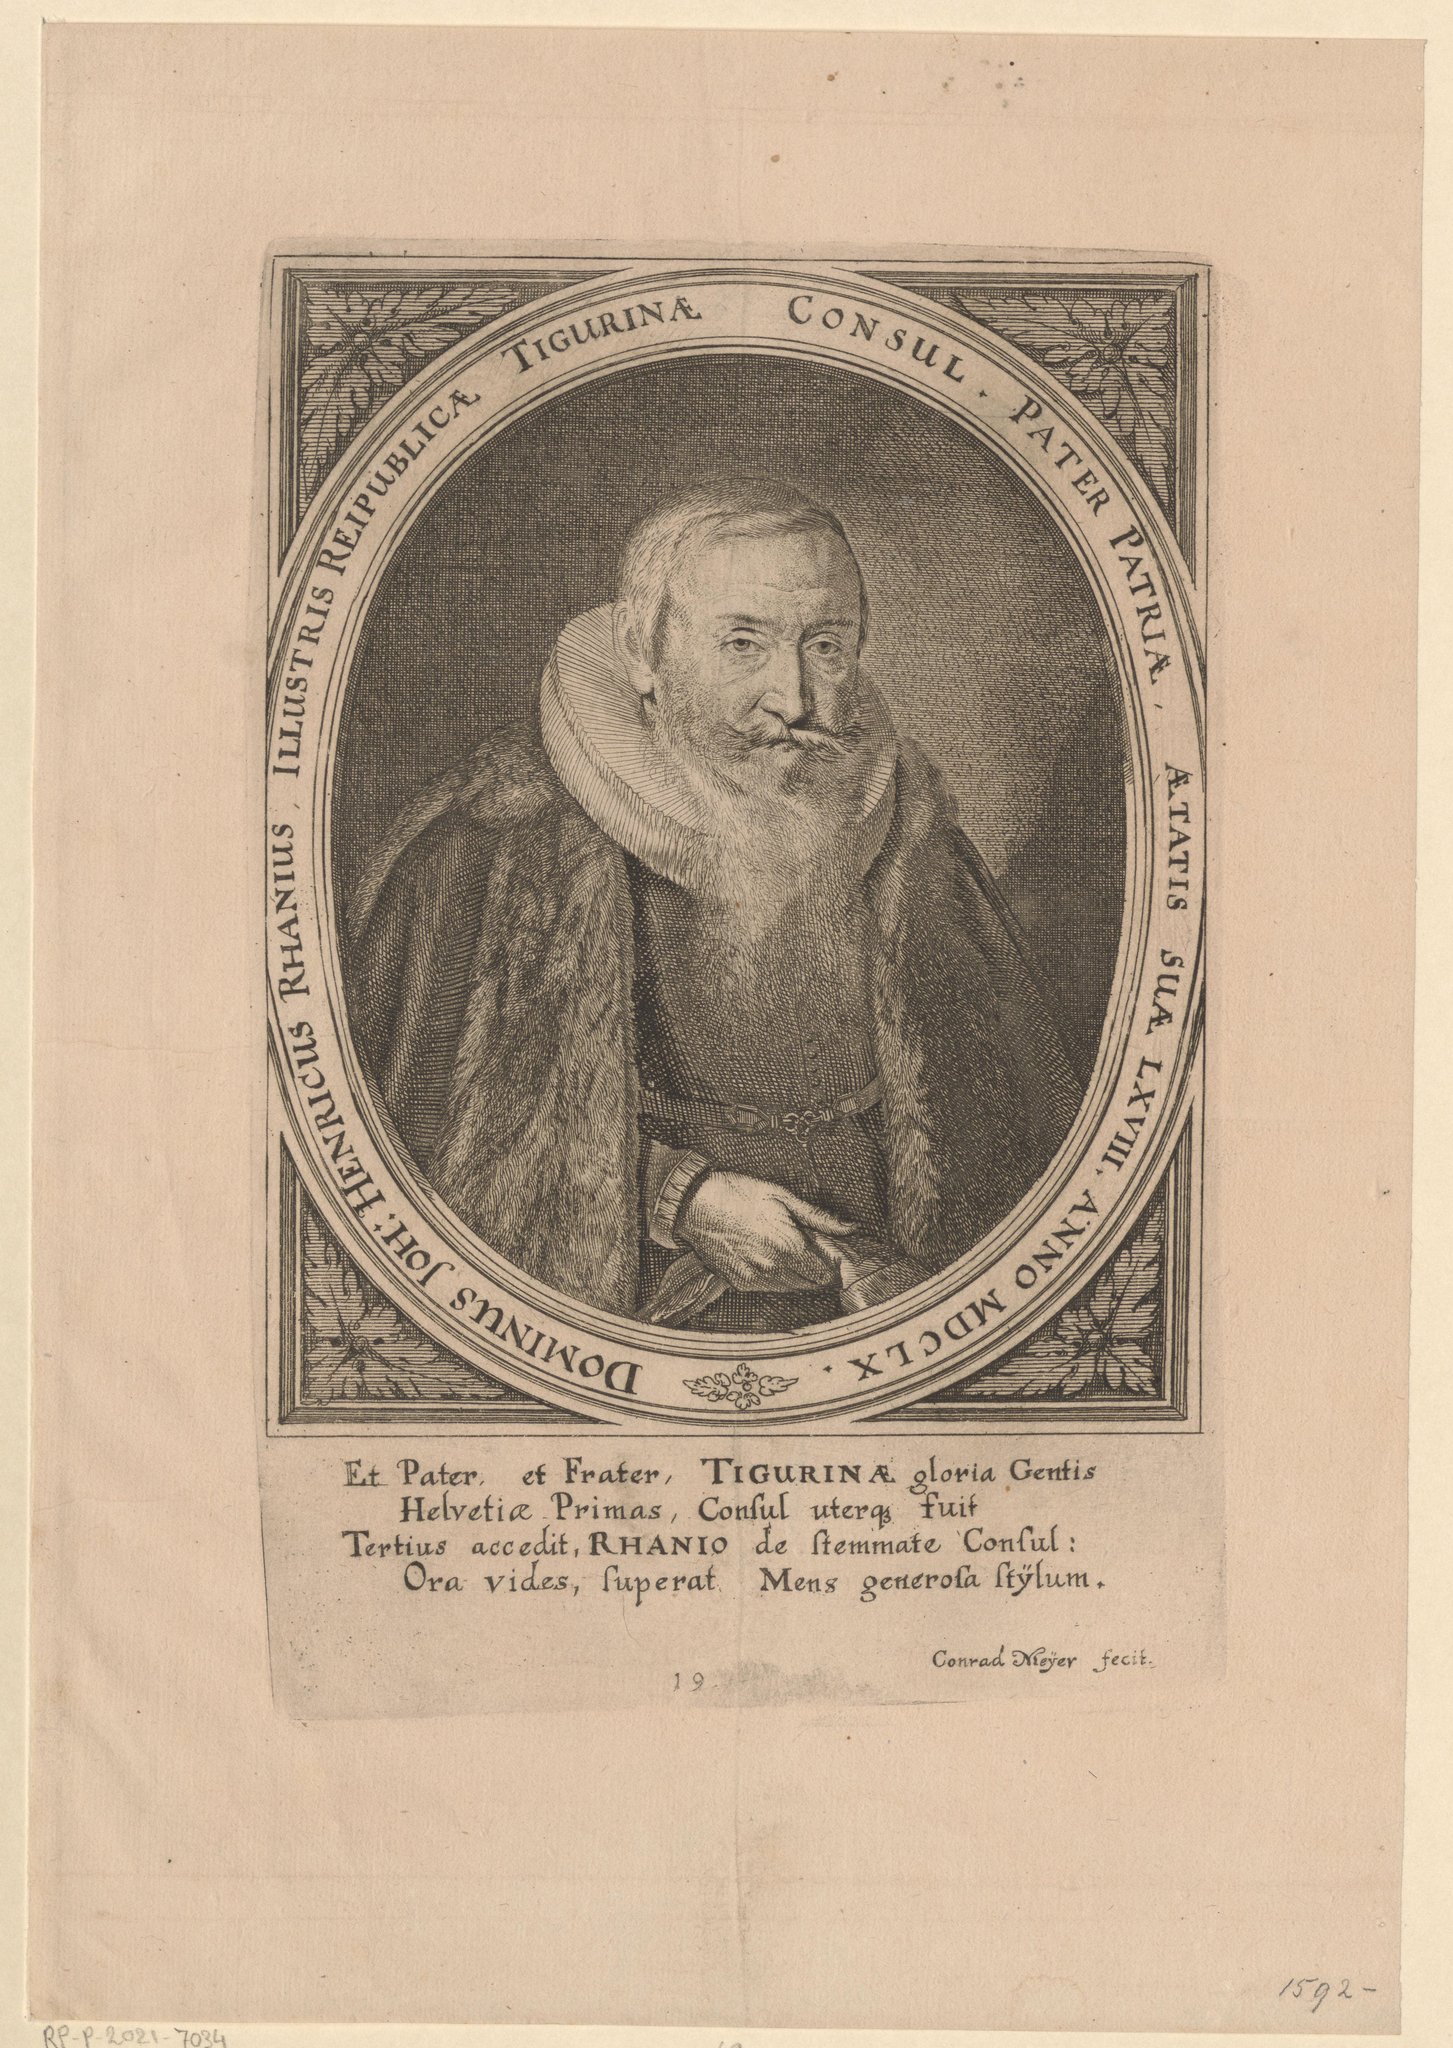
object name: print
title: Portretten van burgemeesters van Zürich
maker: conrad meyer (i)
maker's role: painter, print maker, publisher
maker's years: 1618-1689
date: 1679-1689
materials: paper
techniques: engraving, etching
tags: historical persons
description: Onderdeel van een serie van 67(?) portretten van burgemeesters van Zürich.